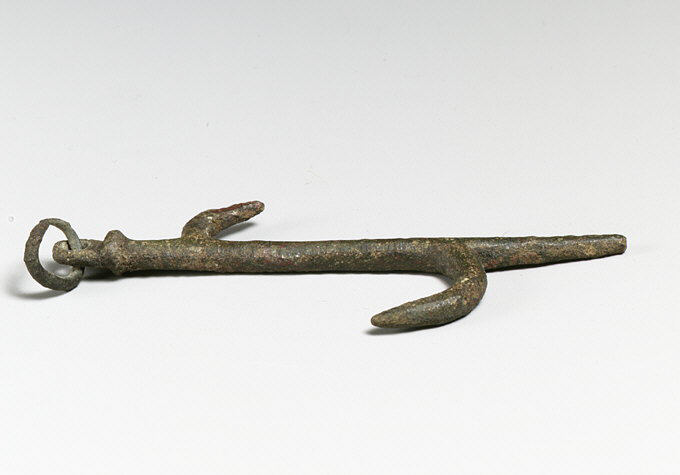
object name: lamp, hook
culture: roman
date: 670 BCE-330 CE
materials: bronze